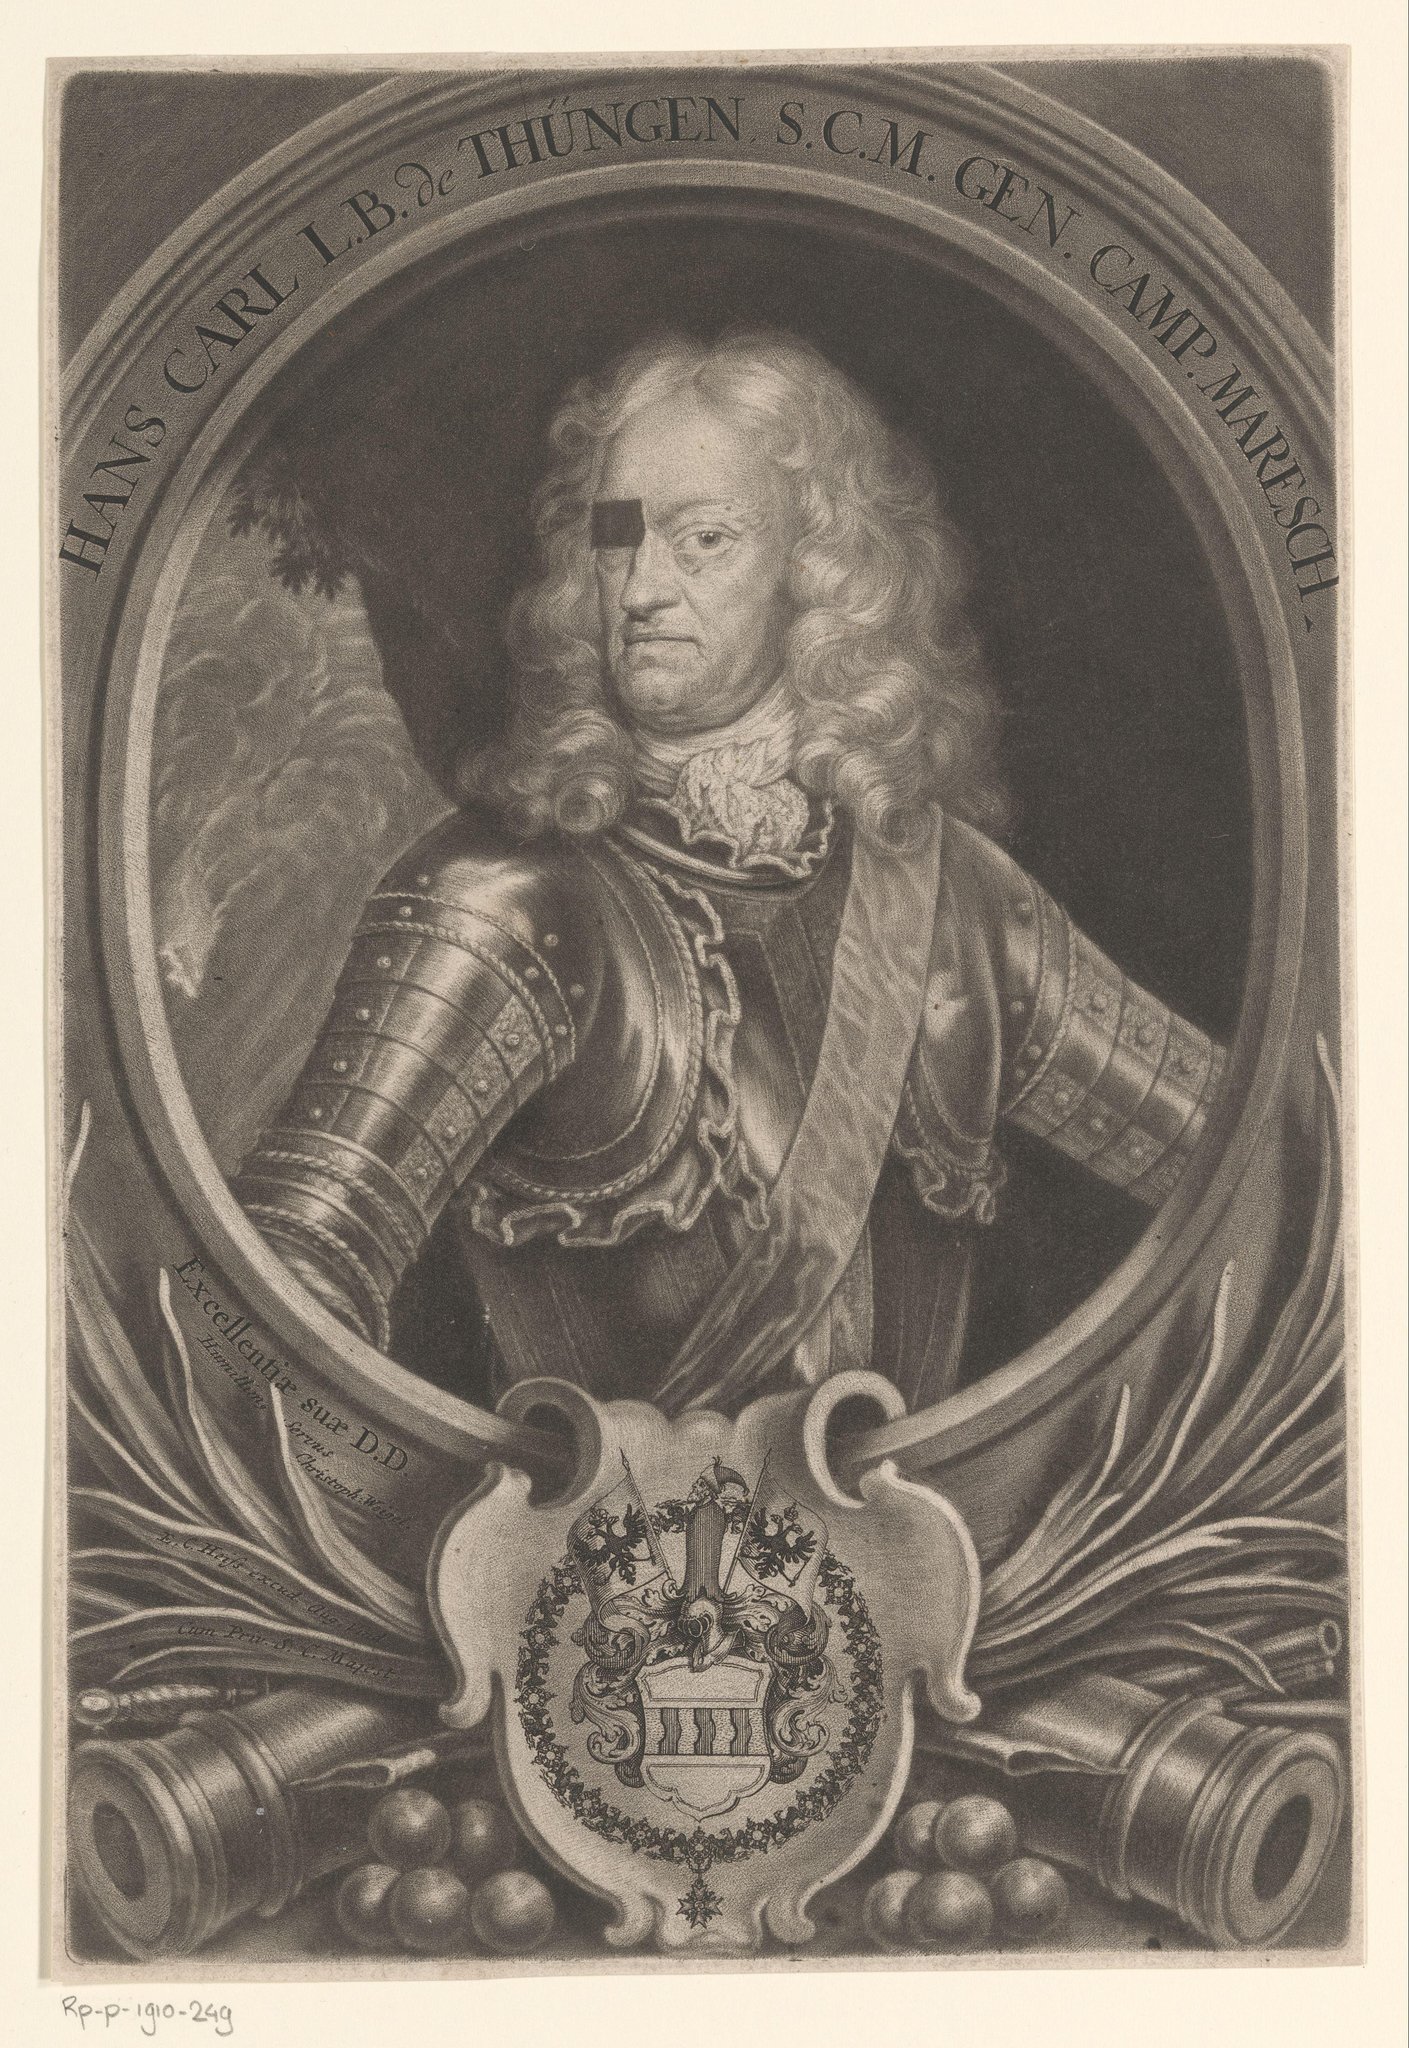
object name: print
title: Portret van Johann Carl von Thüngen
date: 1670-1709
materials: paper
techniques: etching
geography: augsburg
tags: trees: palm-tree (+ branch, stick), armour, historical persons, firearms: cannon, symbols, allegories of war; 'guerra' (ripa), armorial bearing, heraldry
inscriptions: collector's mark: Lugt 2228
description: Met een niet uitgewerkte correctie op het linkeroog in de vorm van een zwart vlak.